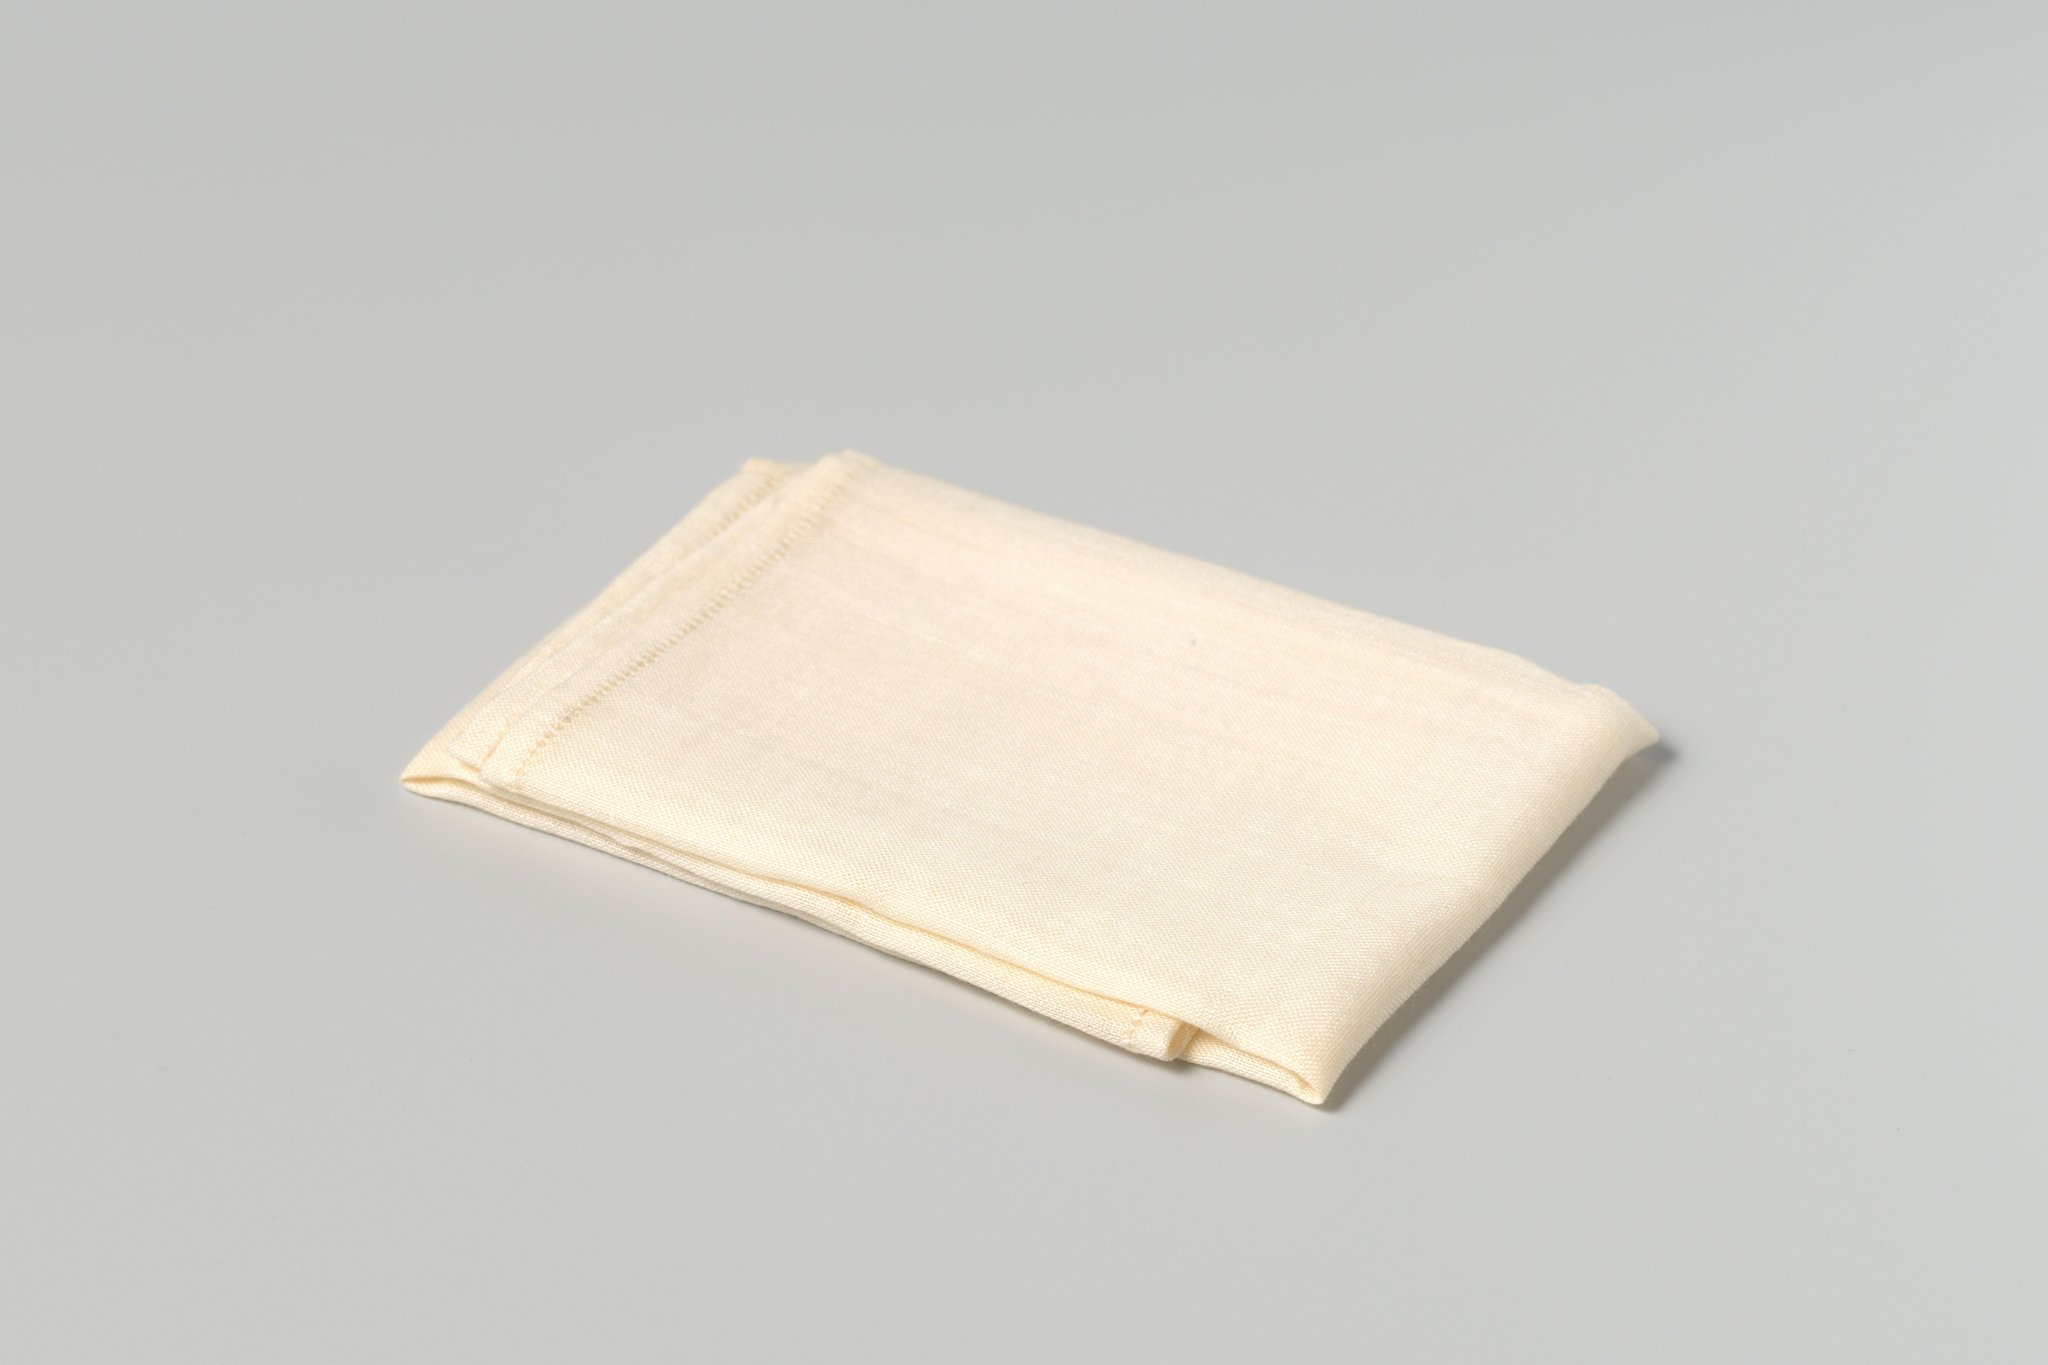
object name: cloth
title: Doek van linnen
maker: Anonymous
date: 1675-1899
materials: linen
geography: netherlands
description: Doek van fijn linnen, aan vier zijden omgezoomd met fijn opengewerkt zoompje